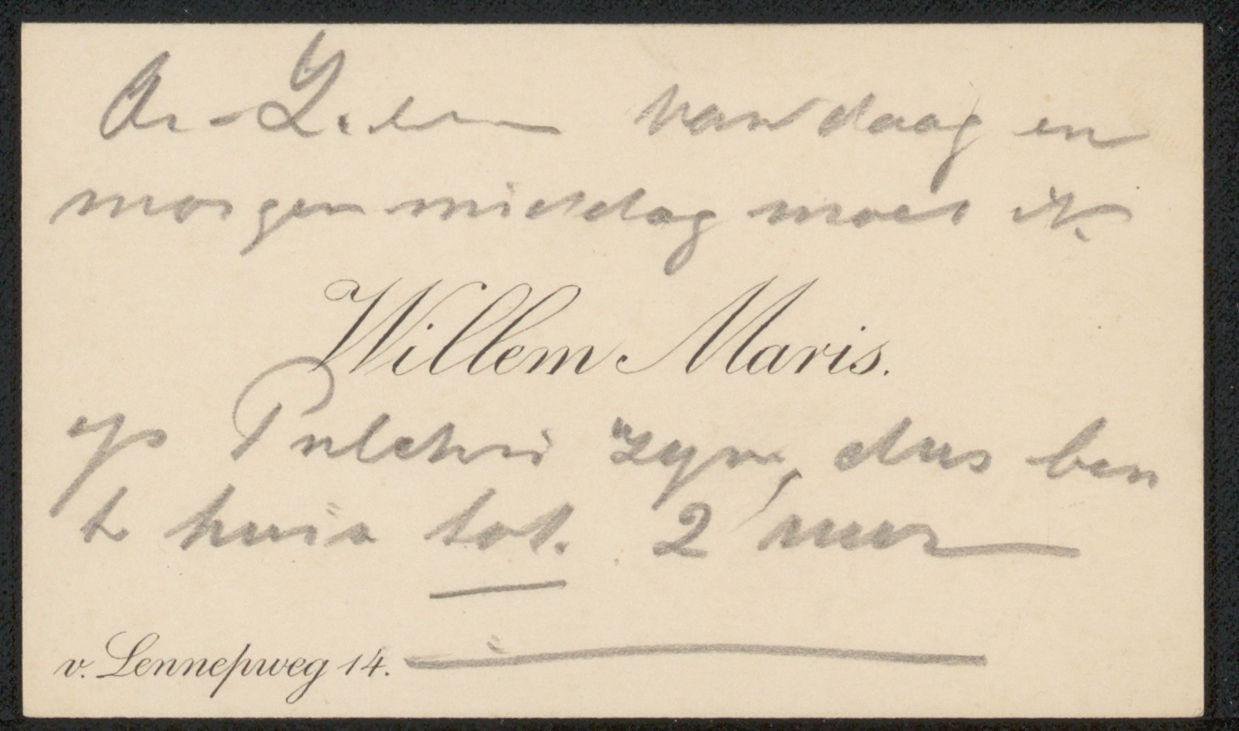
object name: visiting card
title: Visitekaartje aan Philip Zilcken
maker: willem maris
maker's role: draughtsman, painter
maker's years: 1844-1910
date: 1854-1910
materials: cardboard, ink, pencil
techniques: printing, writing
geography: the hague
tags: painter, draughtsman, philip zilcken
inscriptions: collector's mark: ‘RPK’